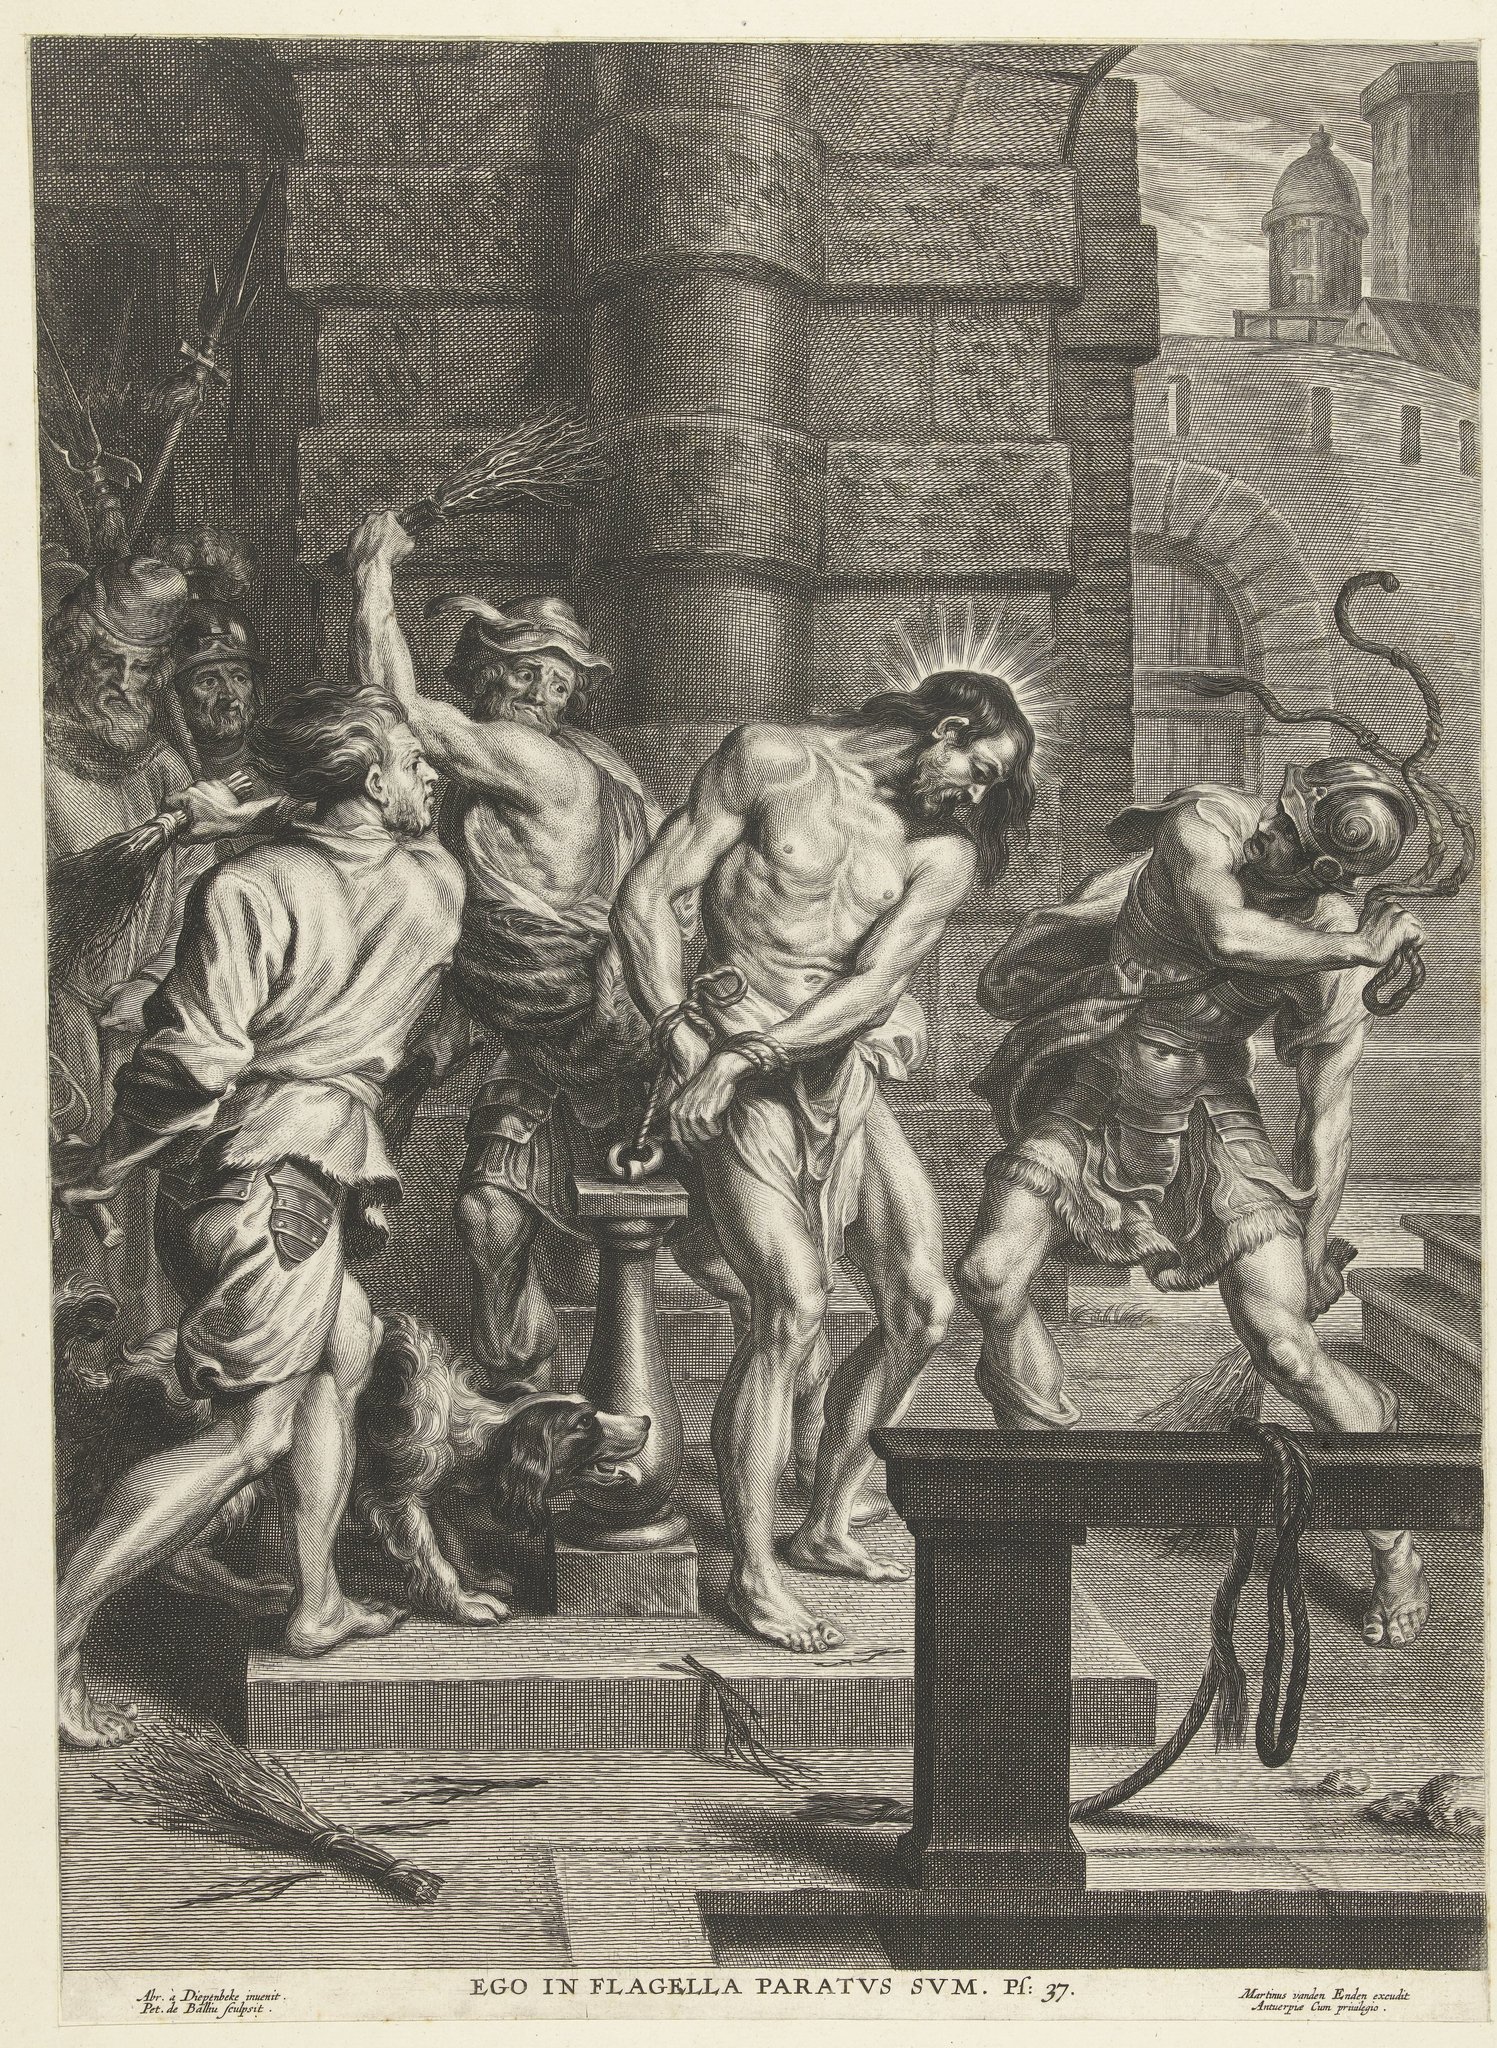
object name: print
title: Geseling van Christus door soldaten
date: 1623-1660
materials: paper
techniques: engraving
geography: antwerp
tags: flagellation by soldiers, christ usually tied to a column (matthew 27:26; mark 15:15; john 19:1)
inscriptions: collector's mark: Lugt 240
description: Prent naar ontwerp van Abraham van Diepenbeeck.